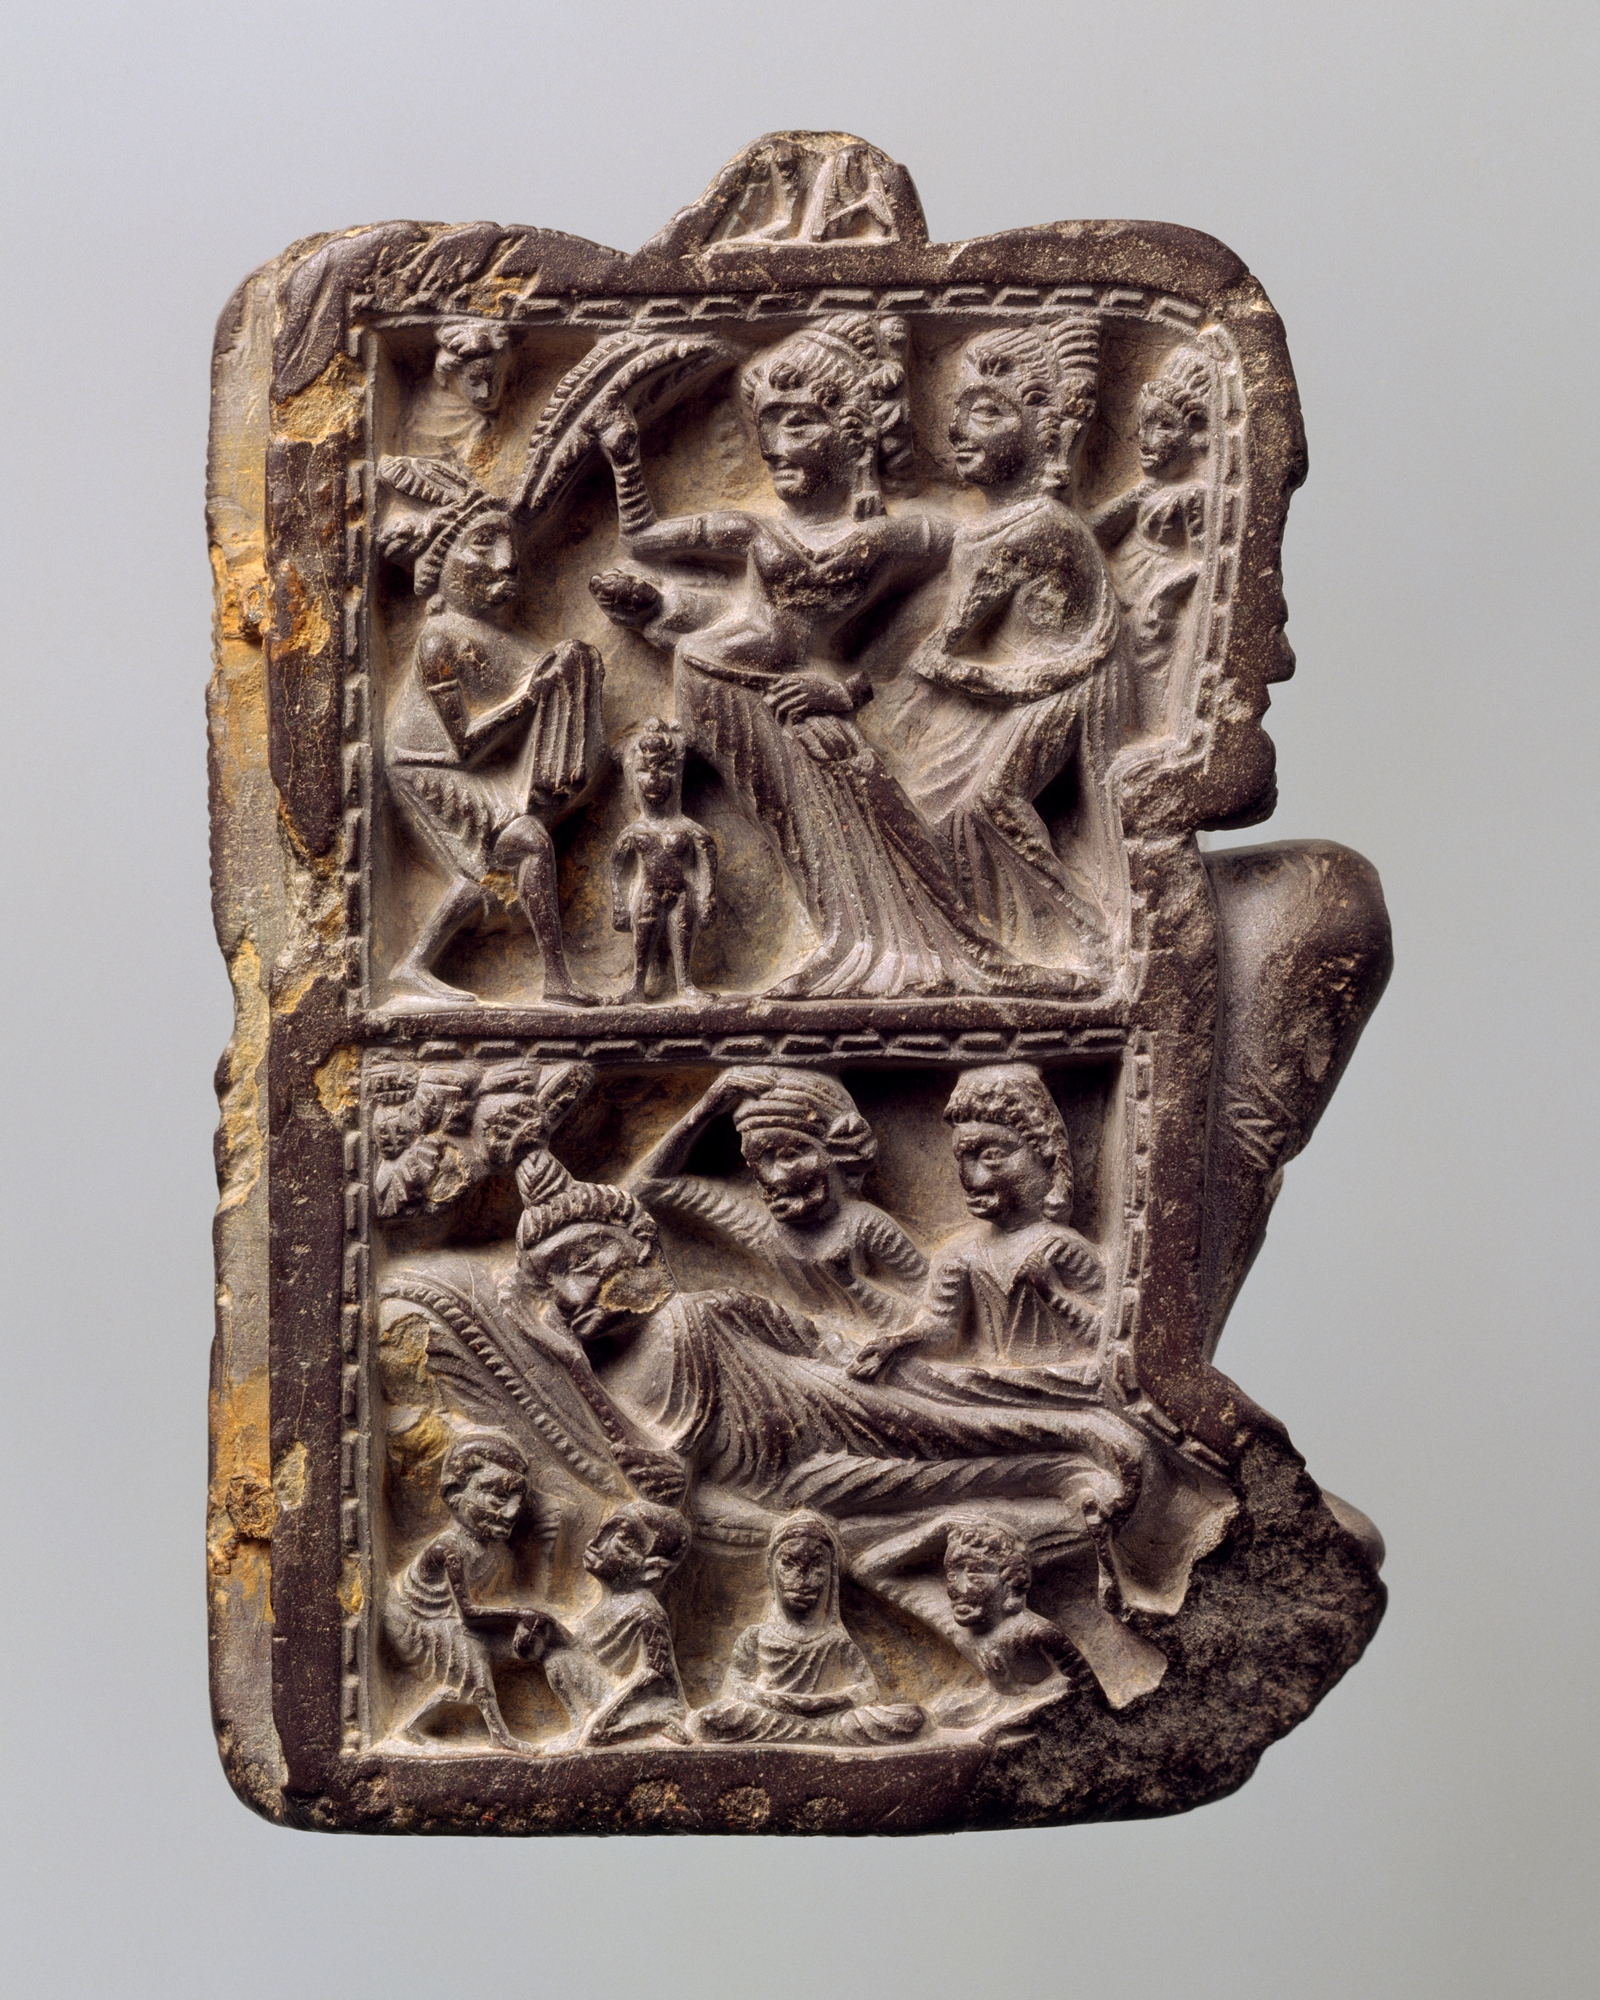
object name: shrine panel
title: Panel of a Portable Shrine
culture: gandhara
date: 401-600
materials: stone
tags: gandhara,buddhism,buddha